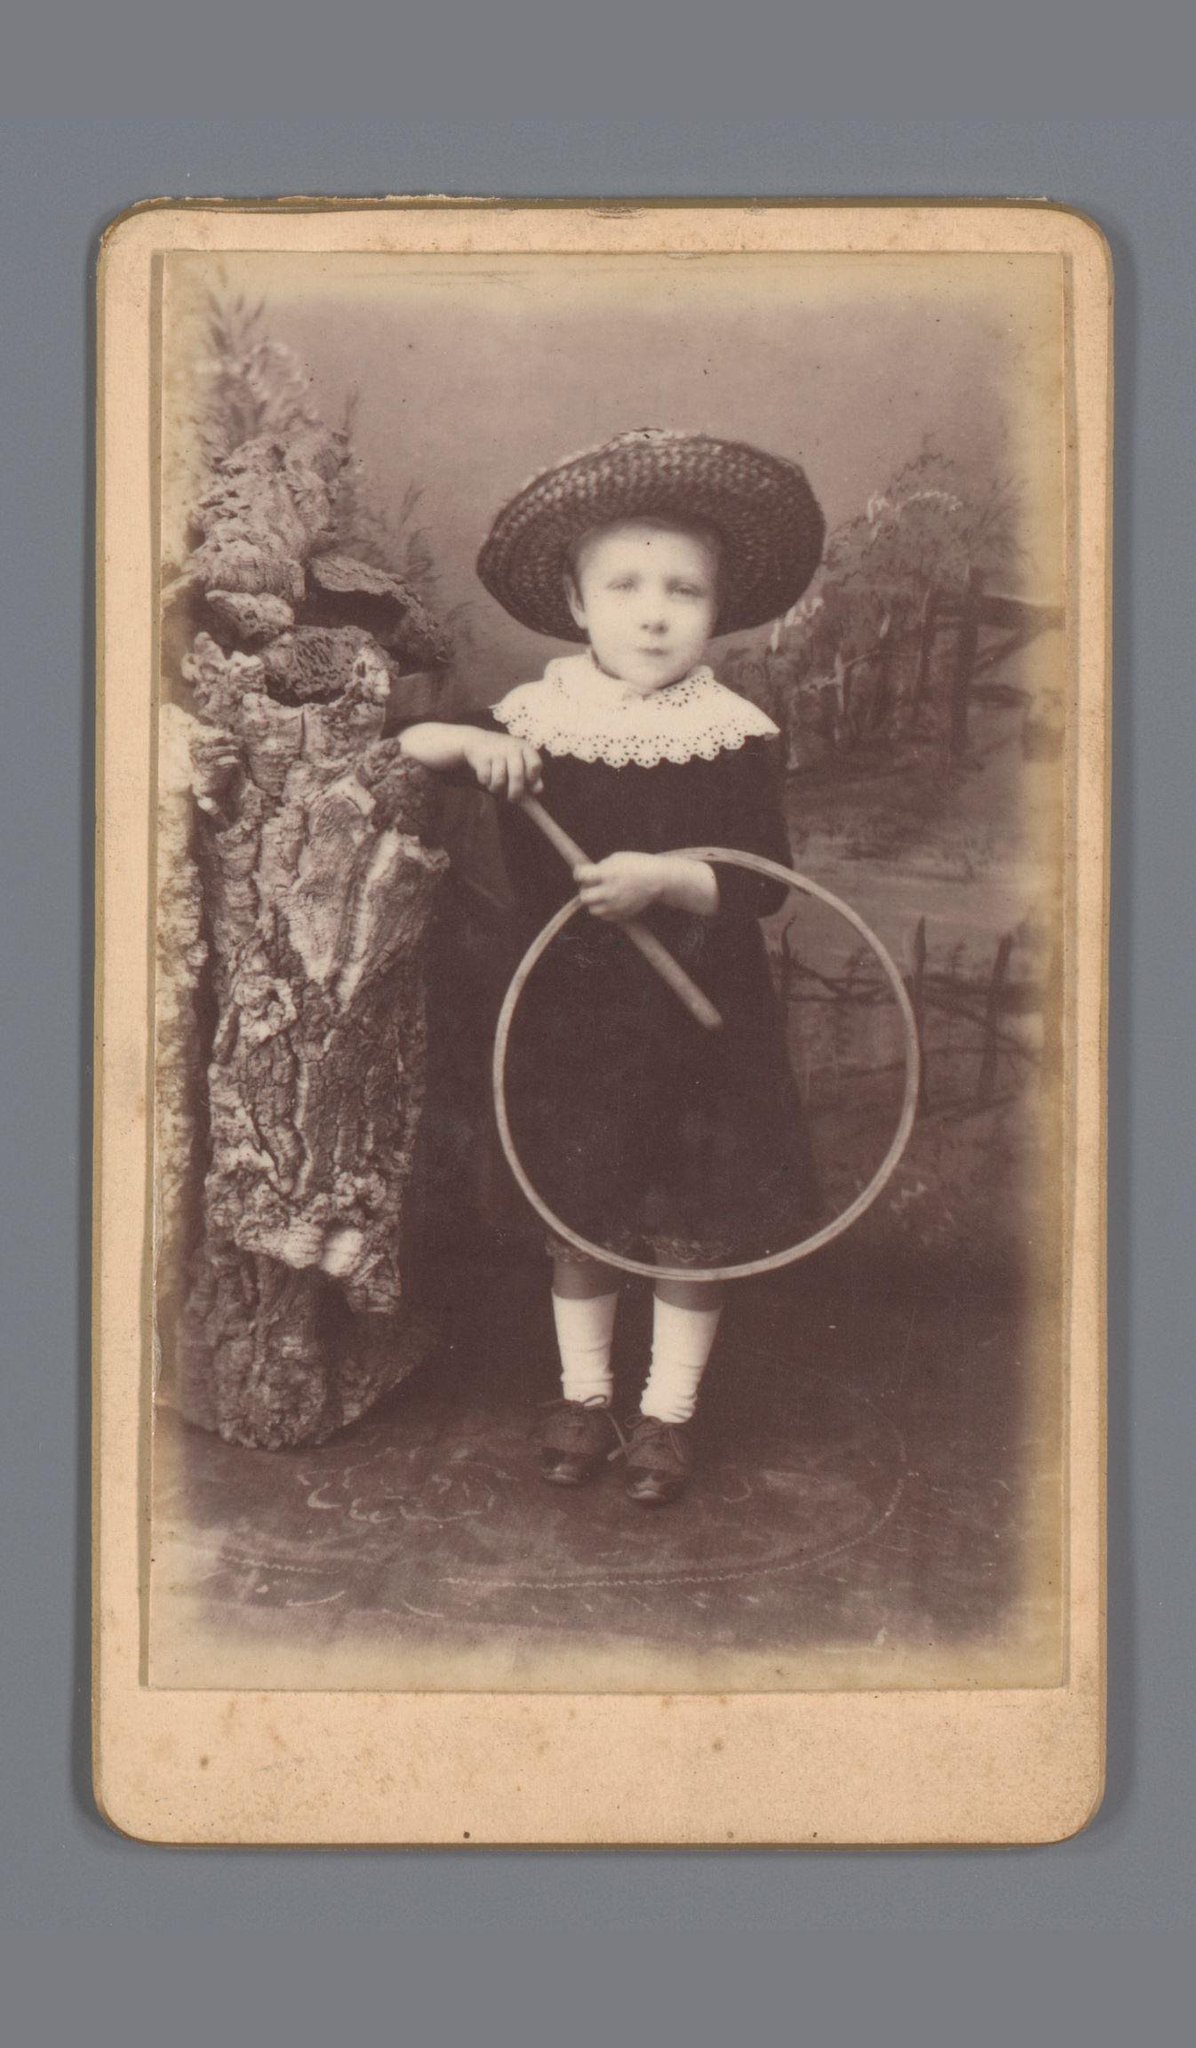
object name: carte de visite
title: Portret van een onbekend kind met een hoepel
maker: Anonymous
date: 1900-1914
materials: cardboard, paper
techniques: albumen print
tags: toddler, (bowling a) hoop, anonymous historical person portrayed